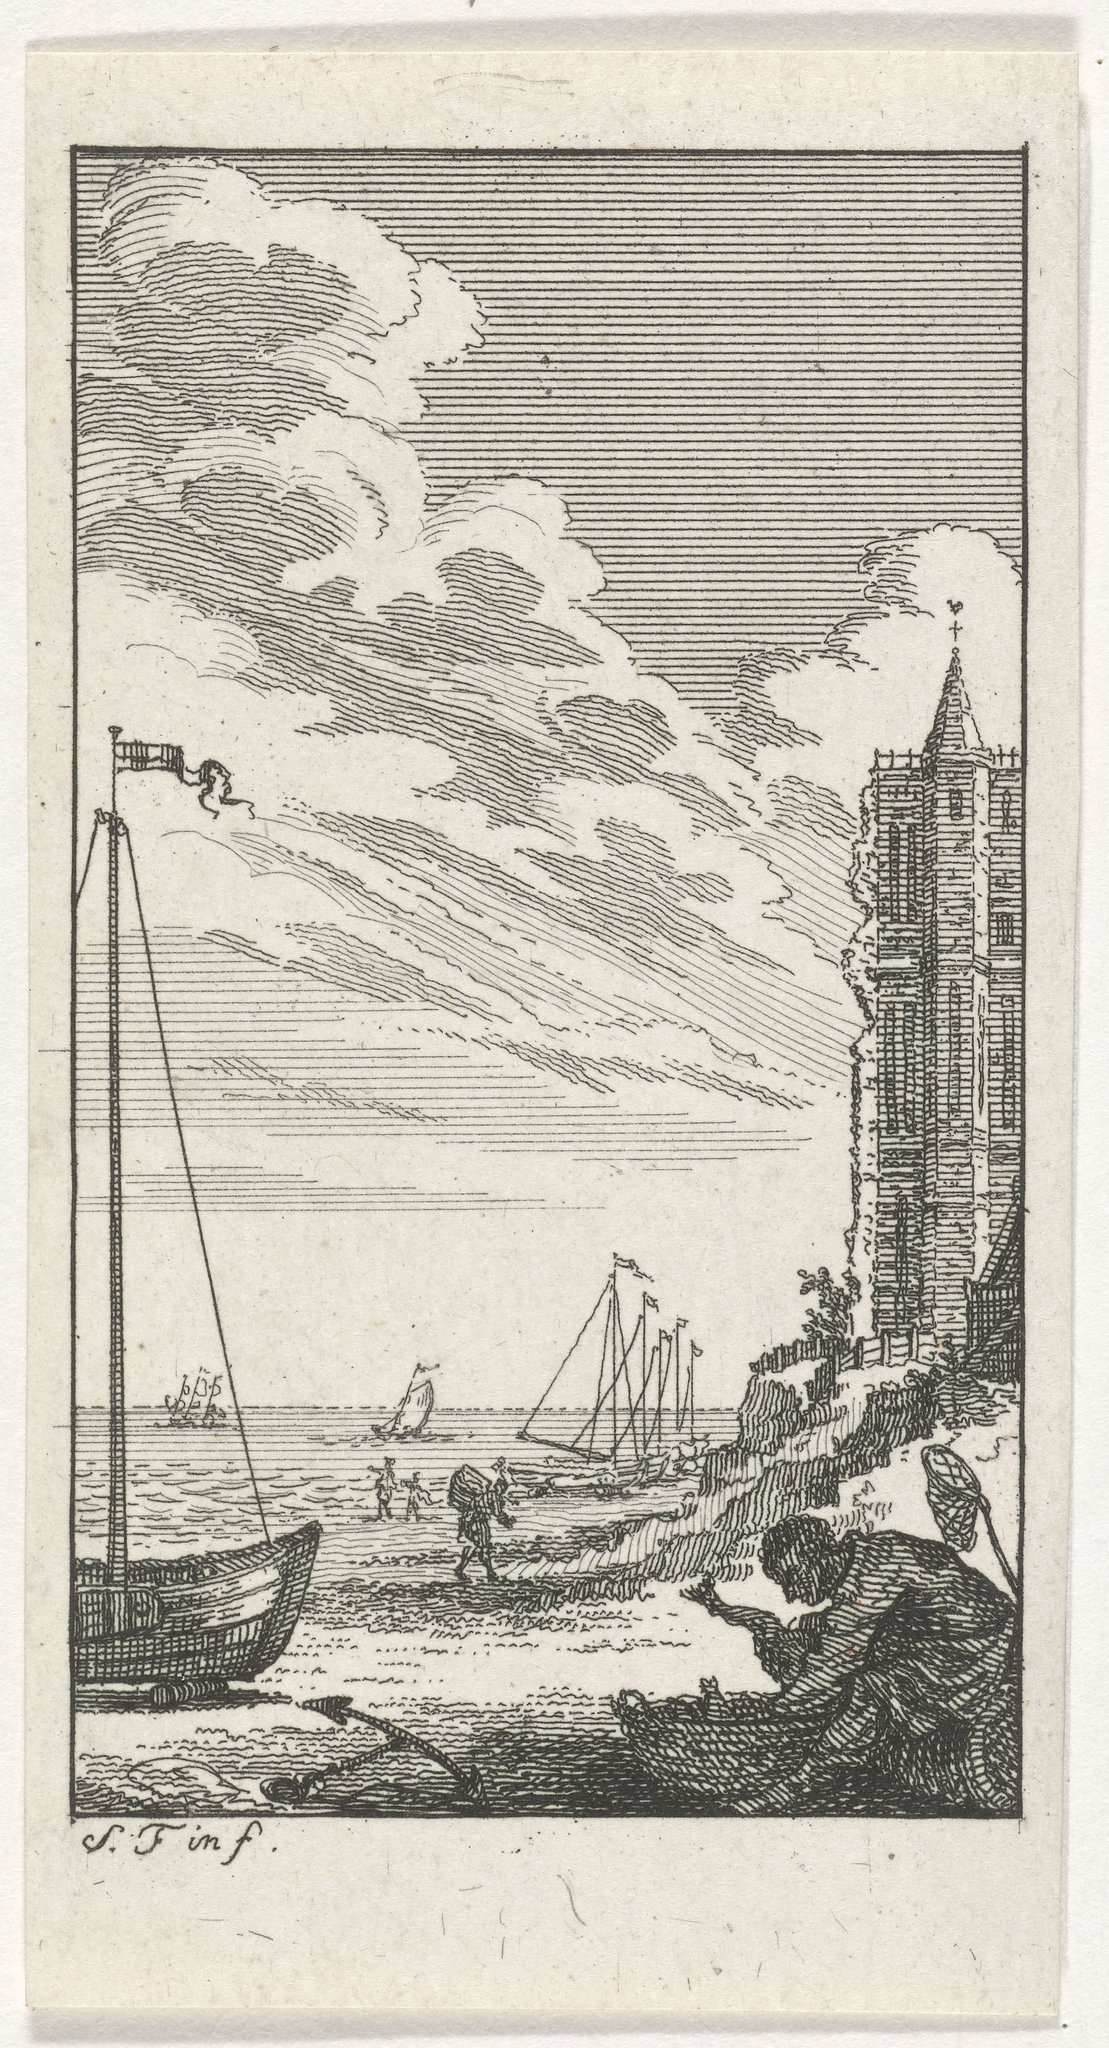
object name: print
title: Maart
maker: simon fokke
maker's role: draughtsman, print maker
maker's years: 1712-1784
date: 1722-1784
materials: paper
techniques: etching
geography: amsterdam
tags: march ~ other concepts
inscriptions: collector's mark: Lugt 240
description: Uit een serie van twaalf prenten, de verbeelding van de maand maart. Zicht op het strand met vissers en boten.